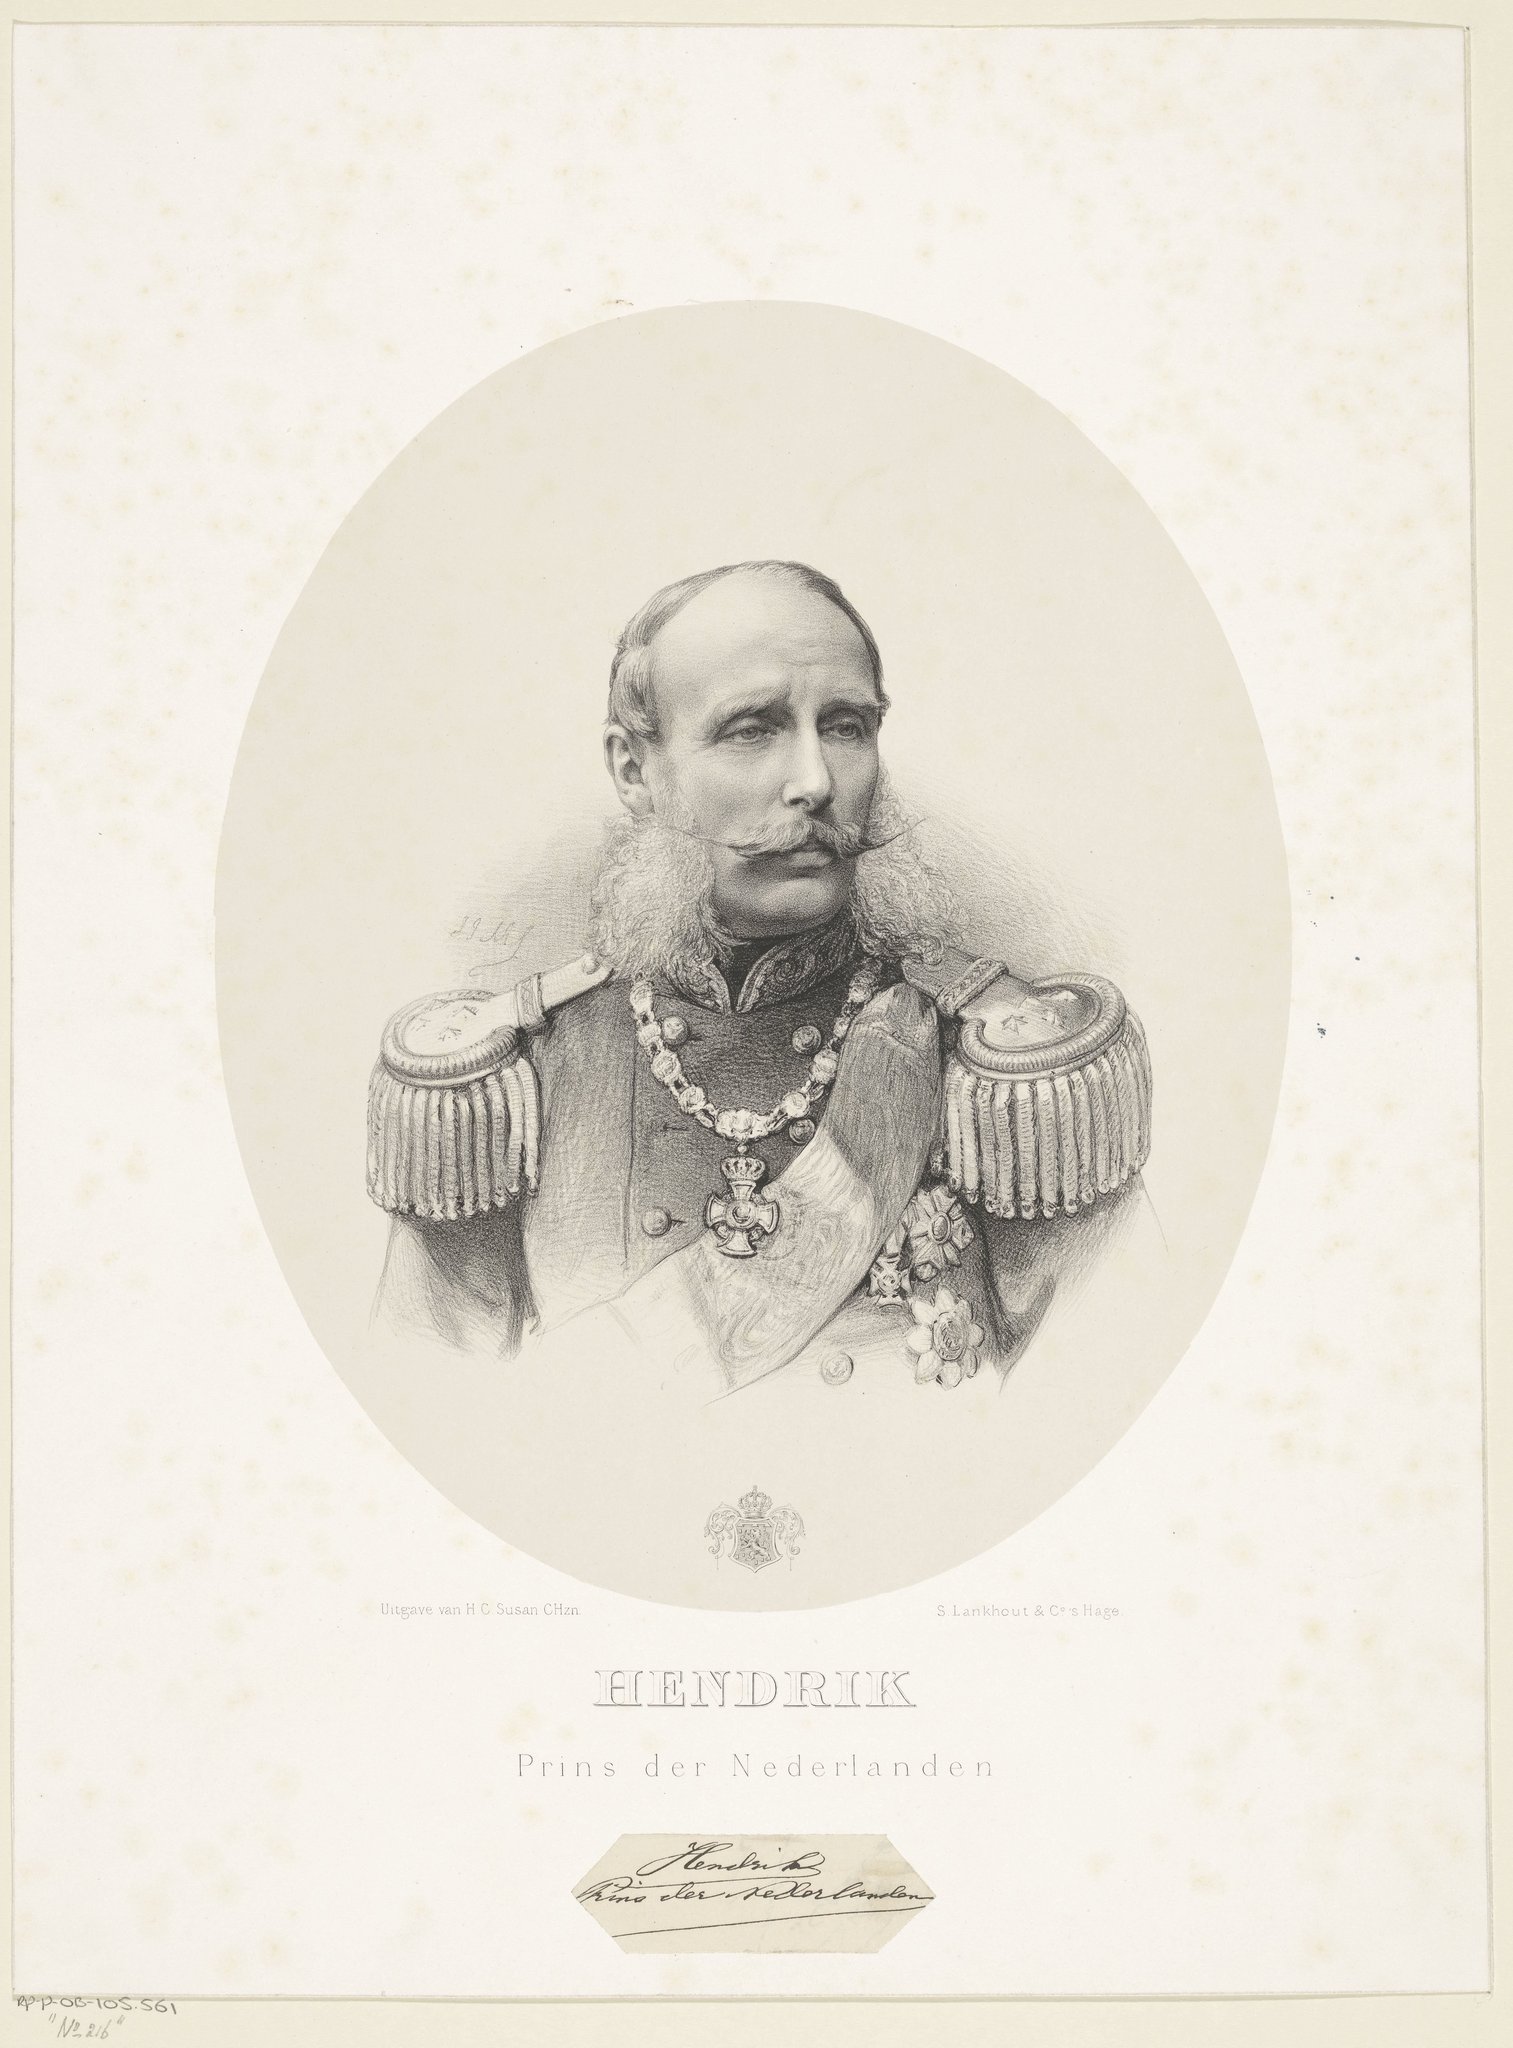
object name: print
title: Portret van Hendrik, prins der Nederlanden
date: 1877-1903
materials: paper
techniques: lithograph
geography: the hague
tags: hendrik (prins der nederlanden)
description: De hier vermelde titel verwijst naar de hoogst verkregen titel van de geportretteerde, niet per se naar de titel die de geportretteerde op deze voorstelling draagt.